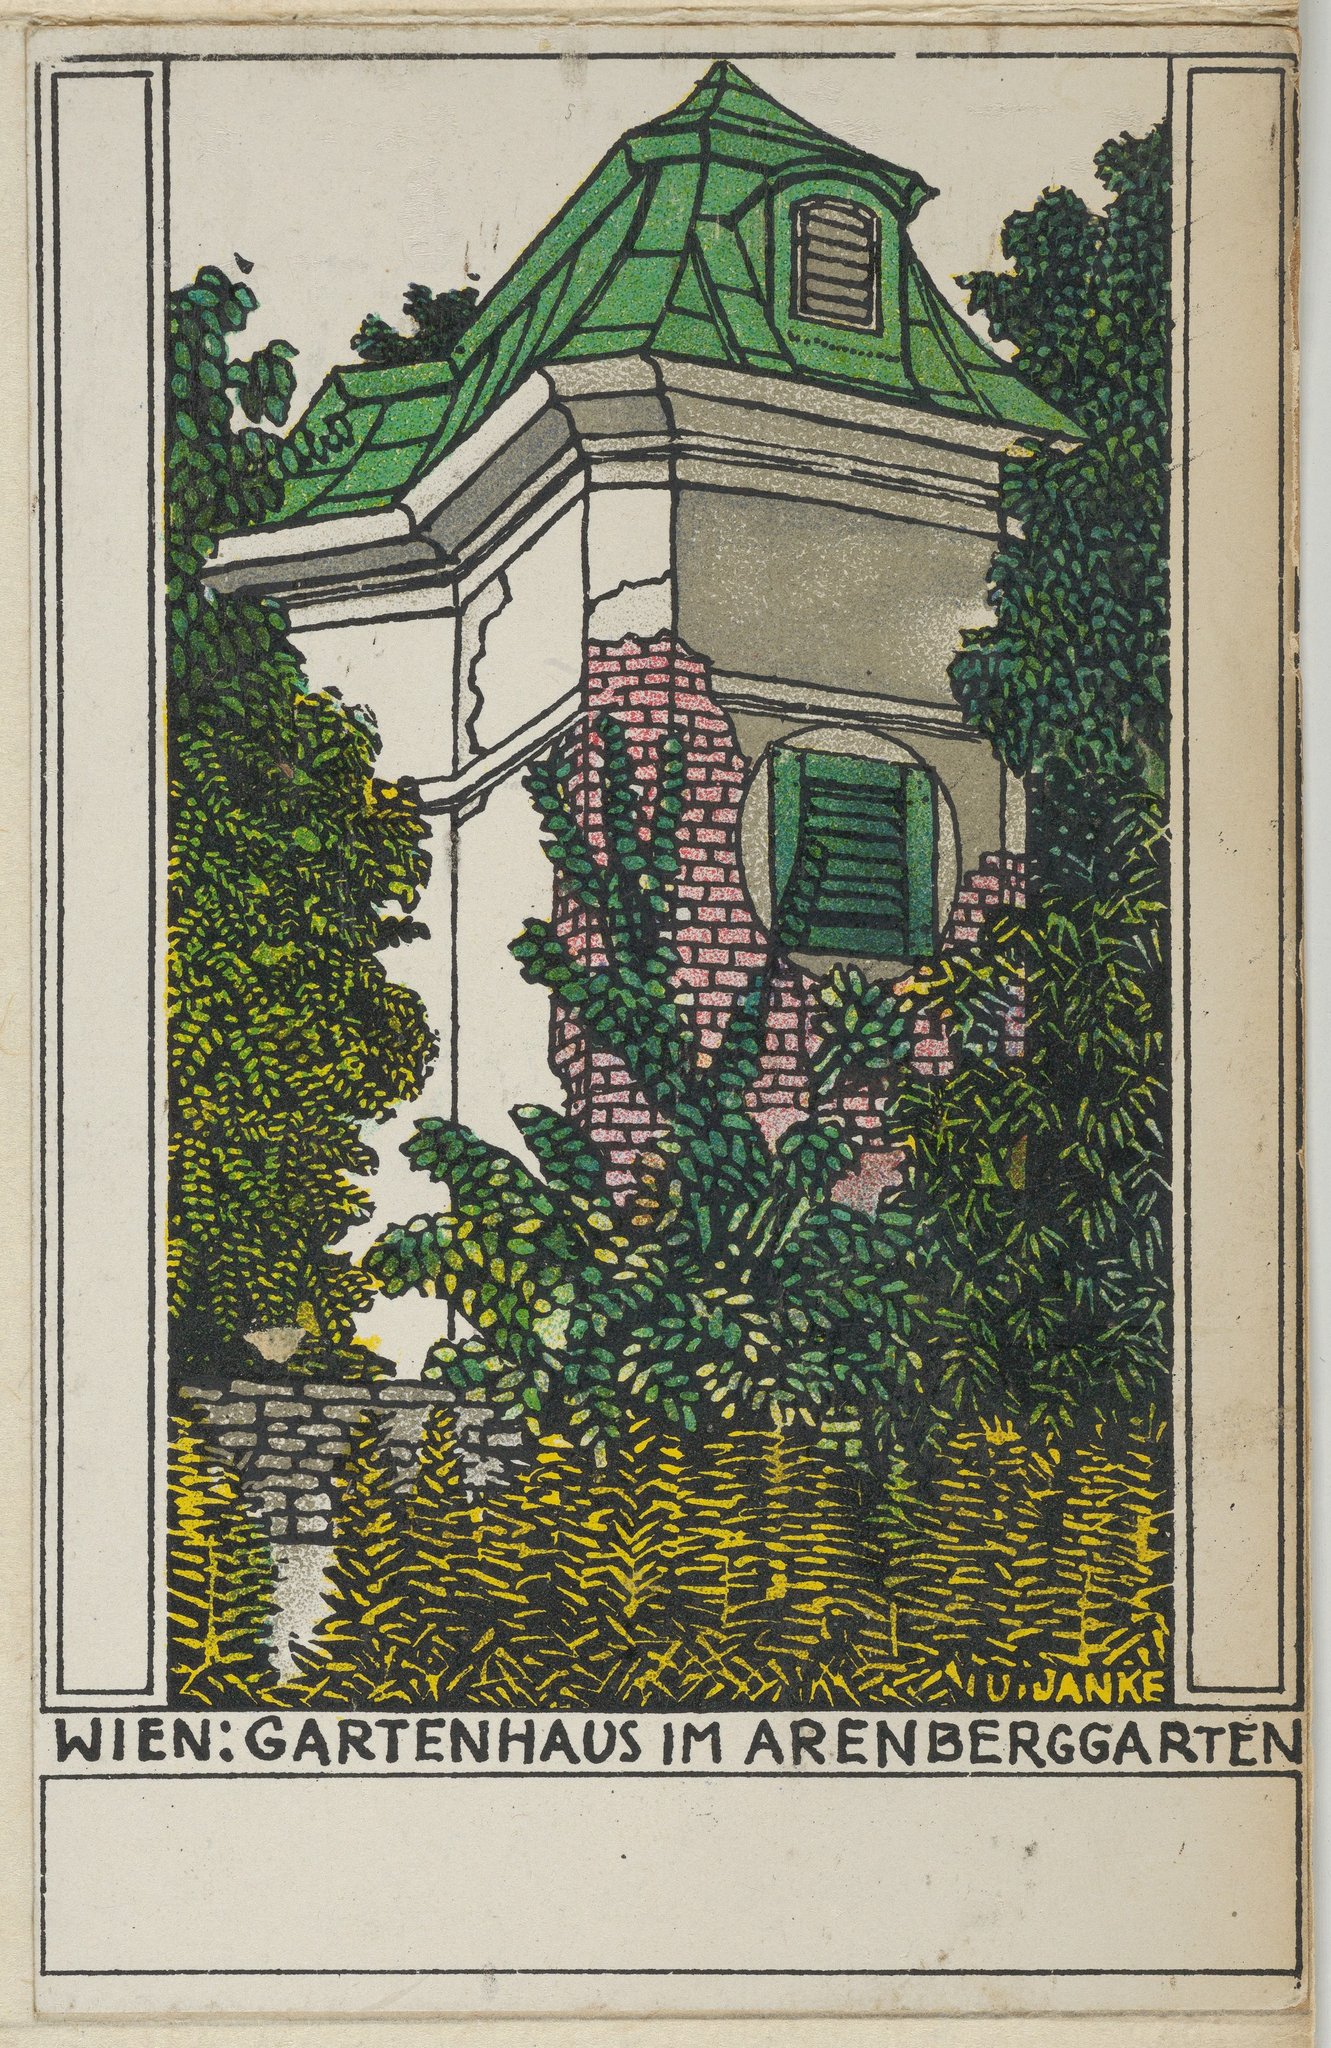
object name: print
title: Vienna: Garden House in the Arenberg Garden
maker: urban janke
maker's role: artist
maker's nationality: austrian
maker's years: 1887-1914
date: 1910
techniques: lithograph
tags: houses,gardens,trees